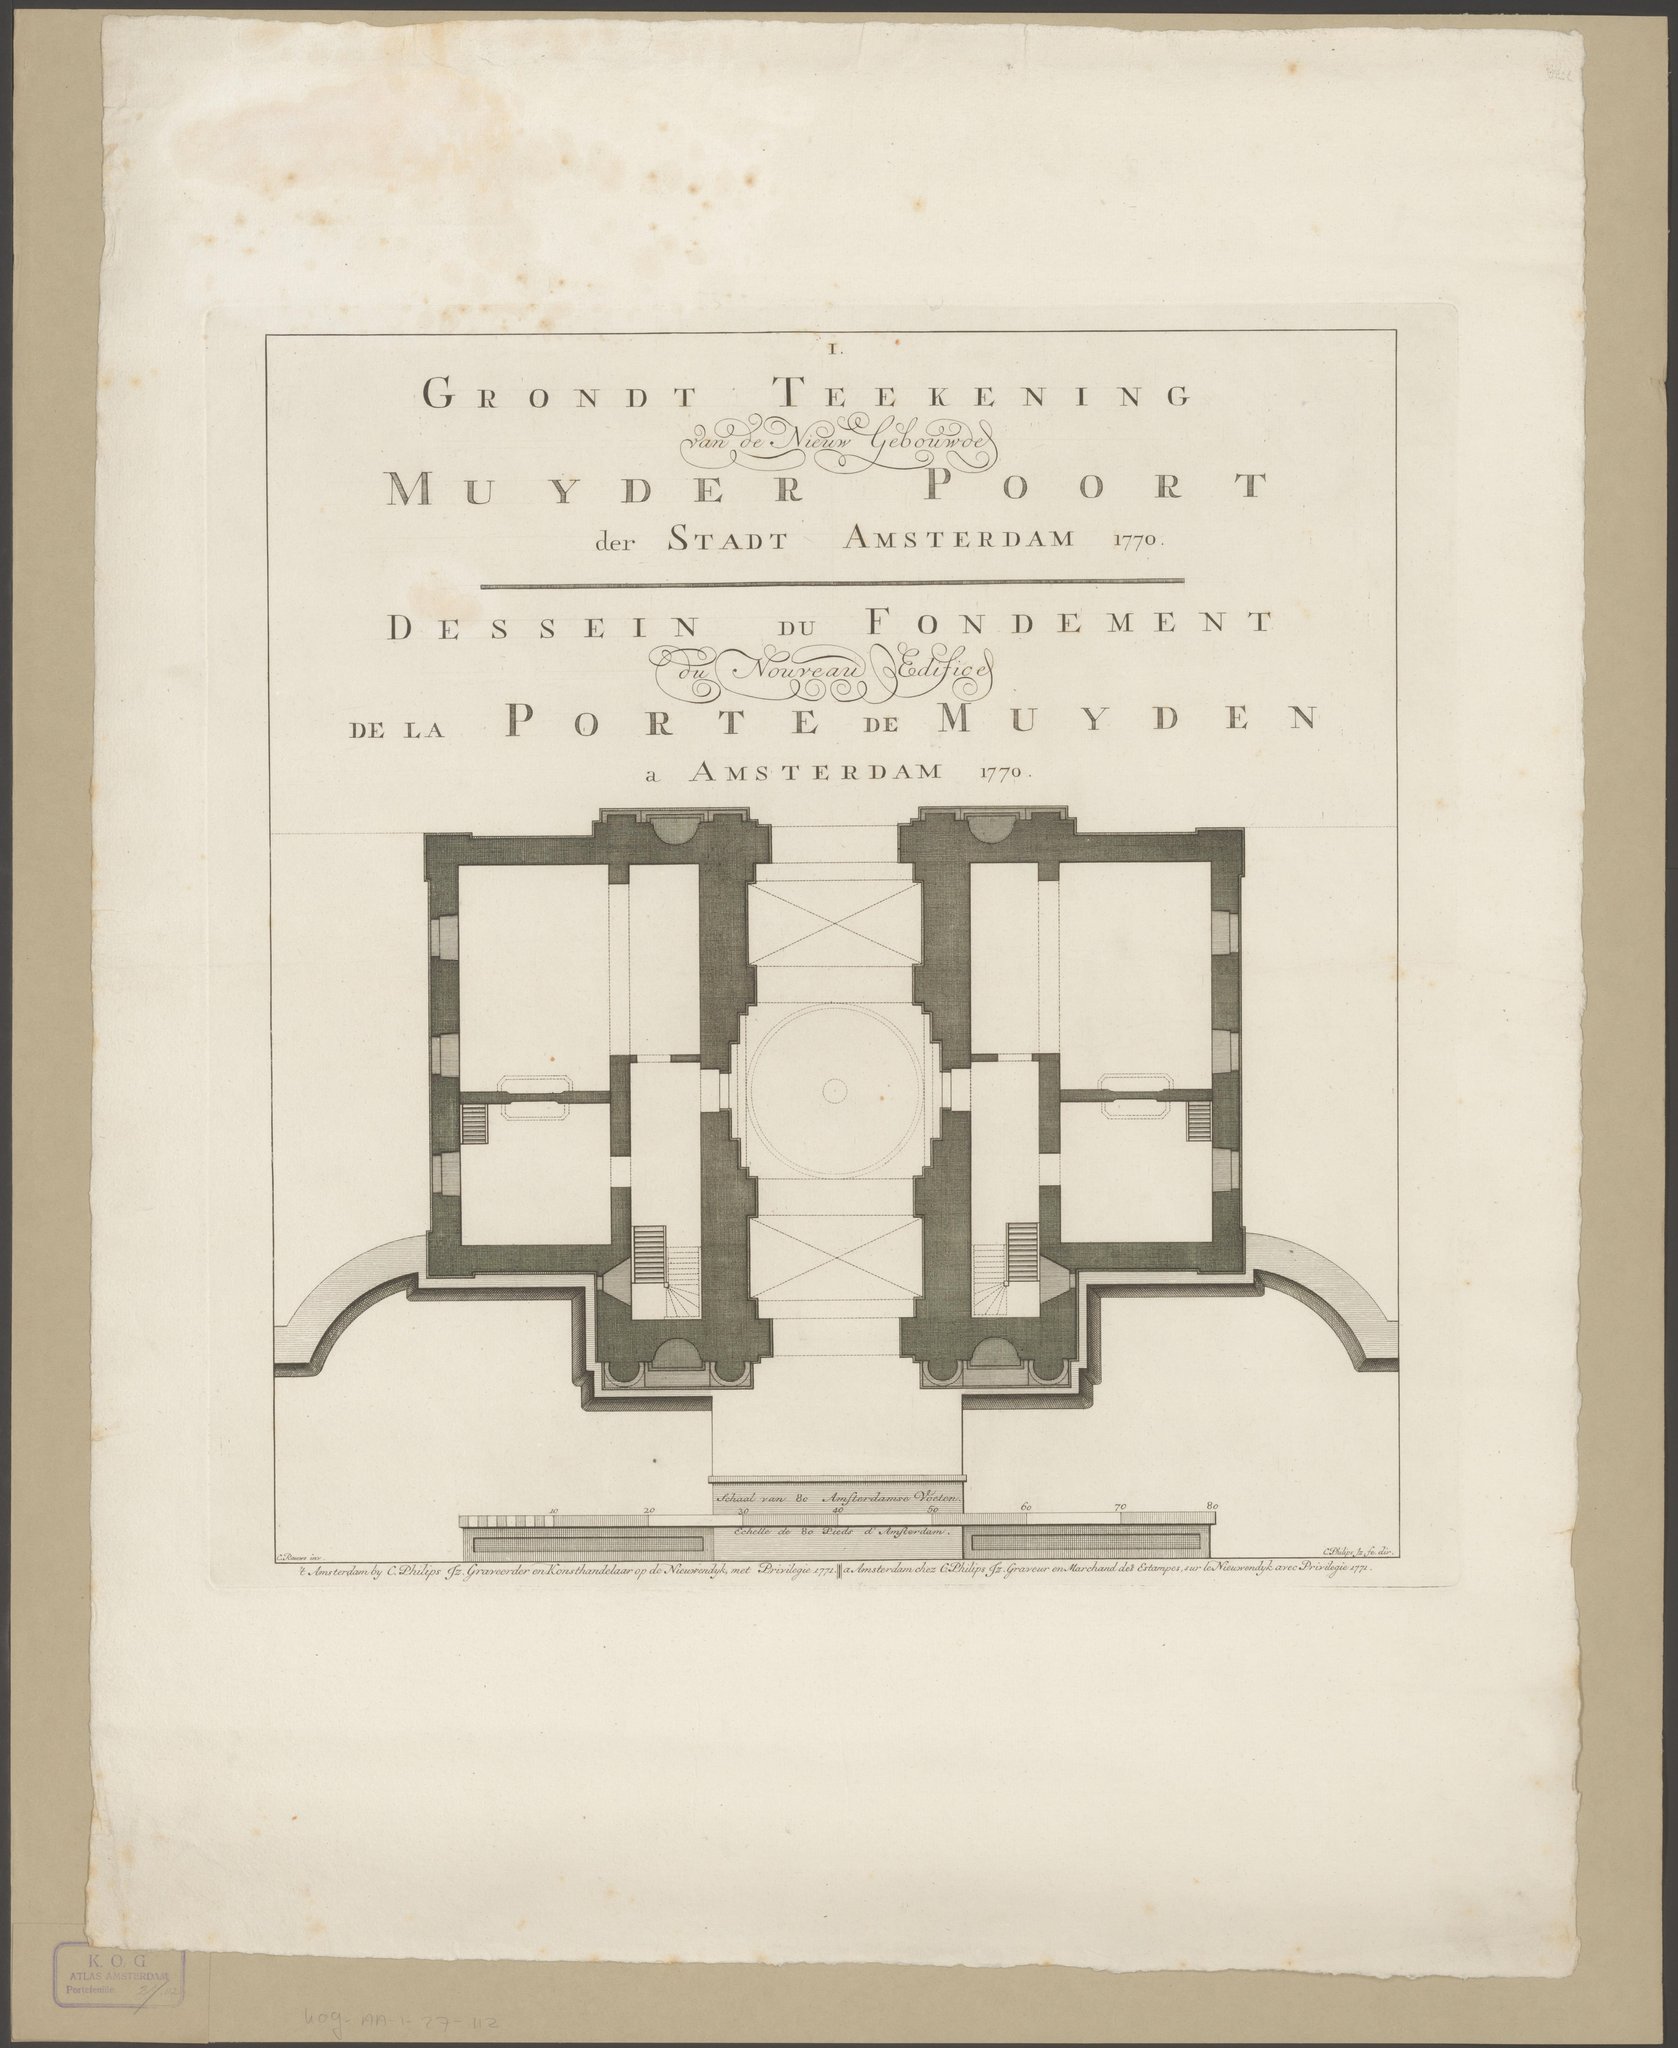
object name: print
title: Ontwerp voor de Tweede Muiderpoort te Amsterdam, 1770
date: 1771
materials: paper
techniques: engraving, etching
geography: amsterdam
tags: plan ~ architecture, series of designs, models, etc. of one architectural project, city-gate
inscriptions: collector's mark: Lugt 1641b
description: Plattegrond van de Tweede Muiderpoort te Amsterdam. Boven de titel in het Nederlands en Frans. Onder een schaalstok: Schaal van 80 Amsterdamse Voeten / Echelle de 80 Pieds d'Amsterdam. Boven in het midden genummerd: I. Onderdeel van een serie van zes prenten van de Tweede Muiderpoort, gemaakt naar de ontwerptekeningen van stadsbouwmeester Cornelis Rauws. Deze stadspoort werd in 1770 gebouwd nadat de Eerste Muiderpoort in 1769 verzakte. Onderwerpsrubriek binnen de Atlas Amsterdam: Poorten, verzamelbladen, J. Tweede Muiderpoort.